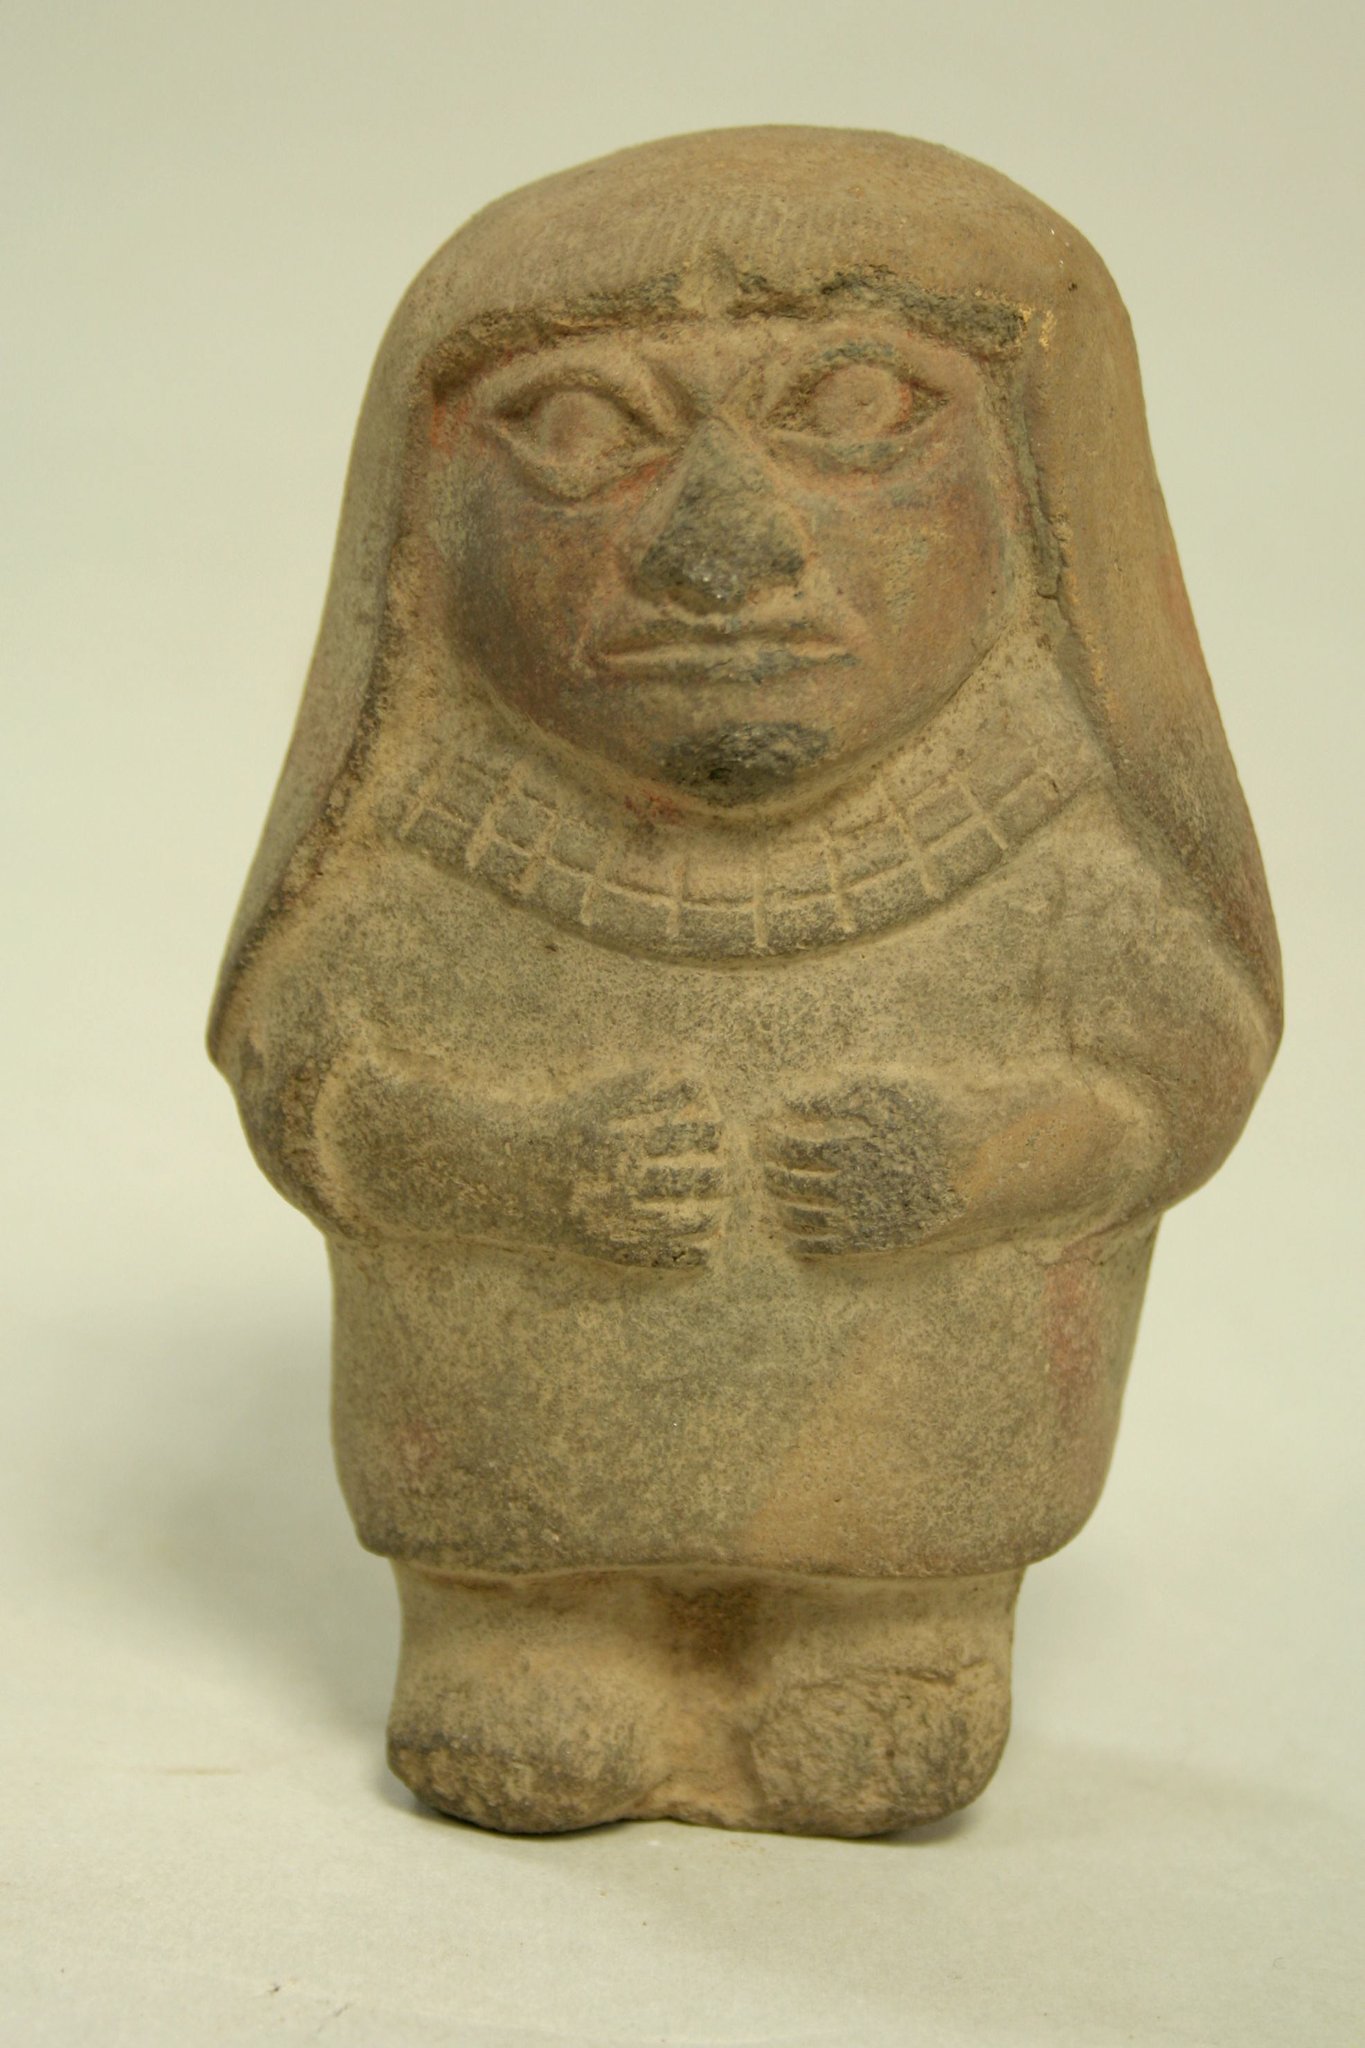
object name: figure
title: Standing Ceramic Figure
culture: moche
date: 201-500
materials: ceramic, pigment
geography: peru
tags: human figures